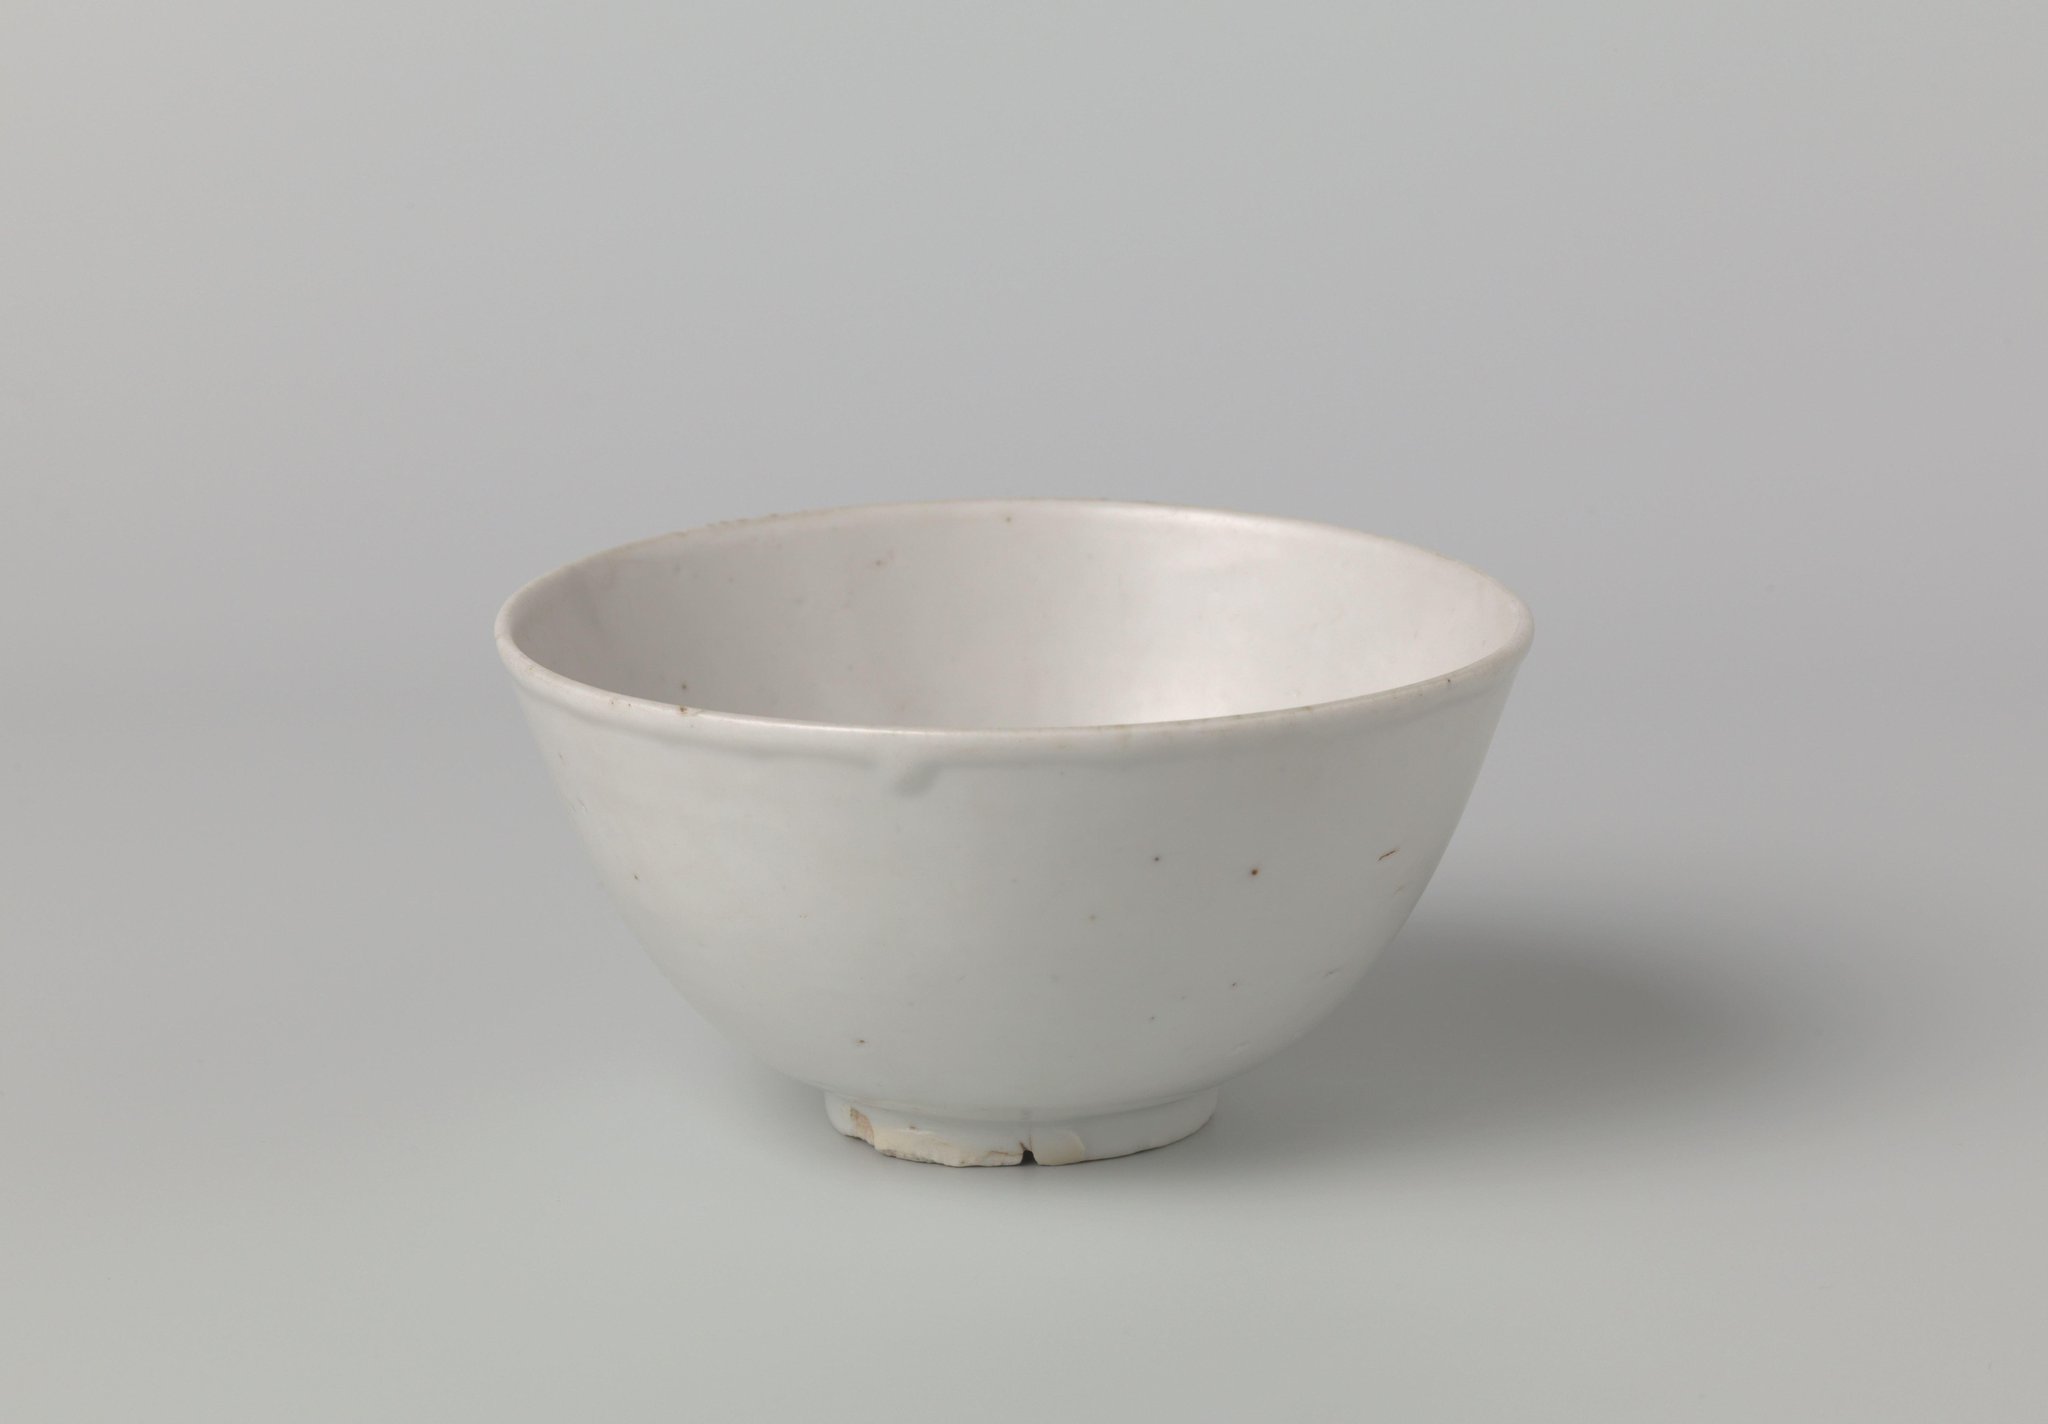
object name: bowl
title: Bowl with a white glaze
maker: Anonymous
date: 1600-1699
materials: glaze, porcelain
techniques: firing, turning, vitrification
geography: south china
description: Kom van porselein, bedekt met een wit glazuur. Wit porselein, monochromen.